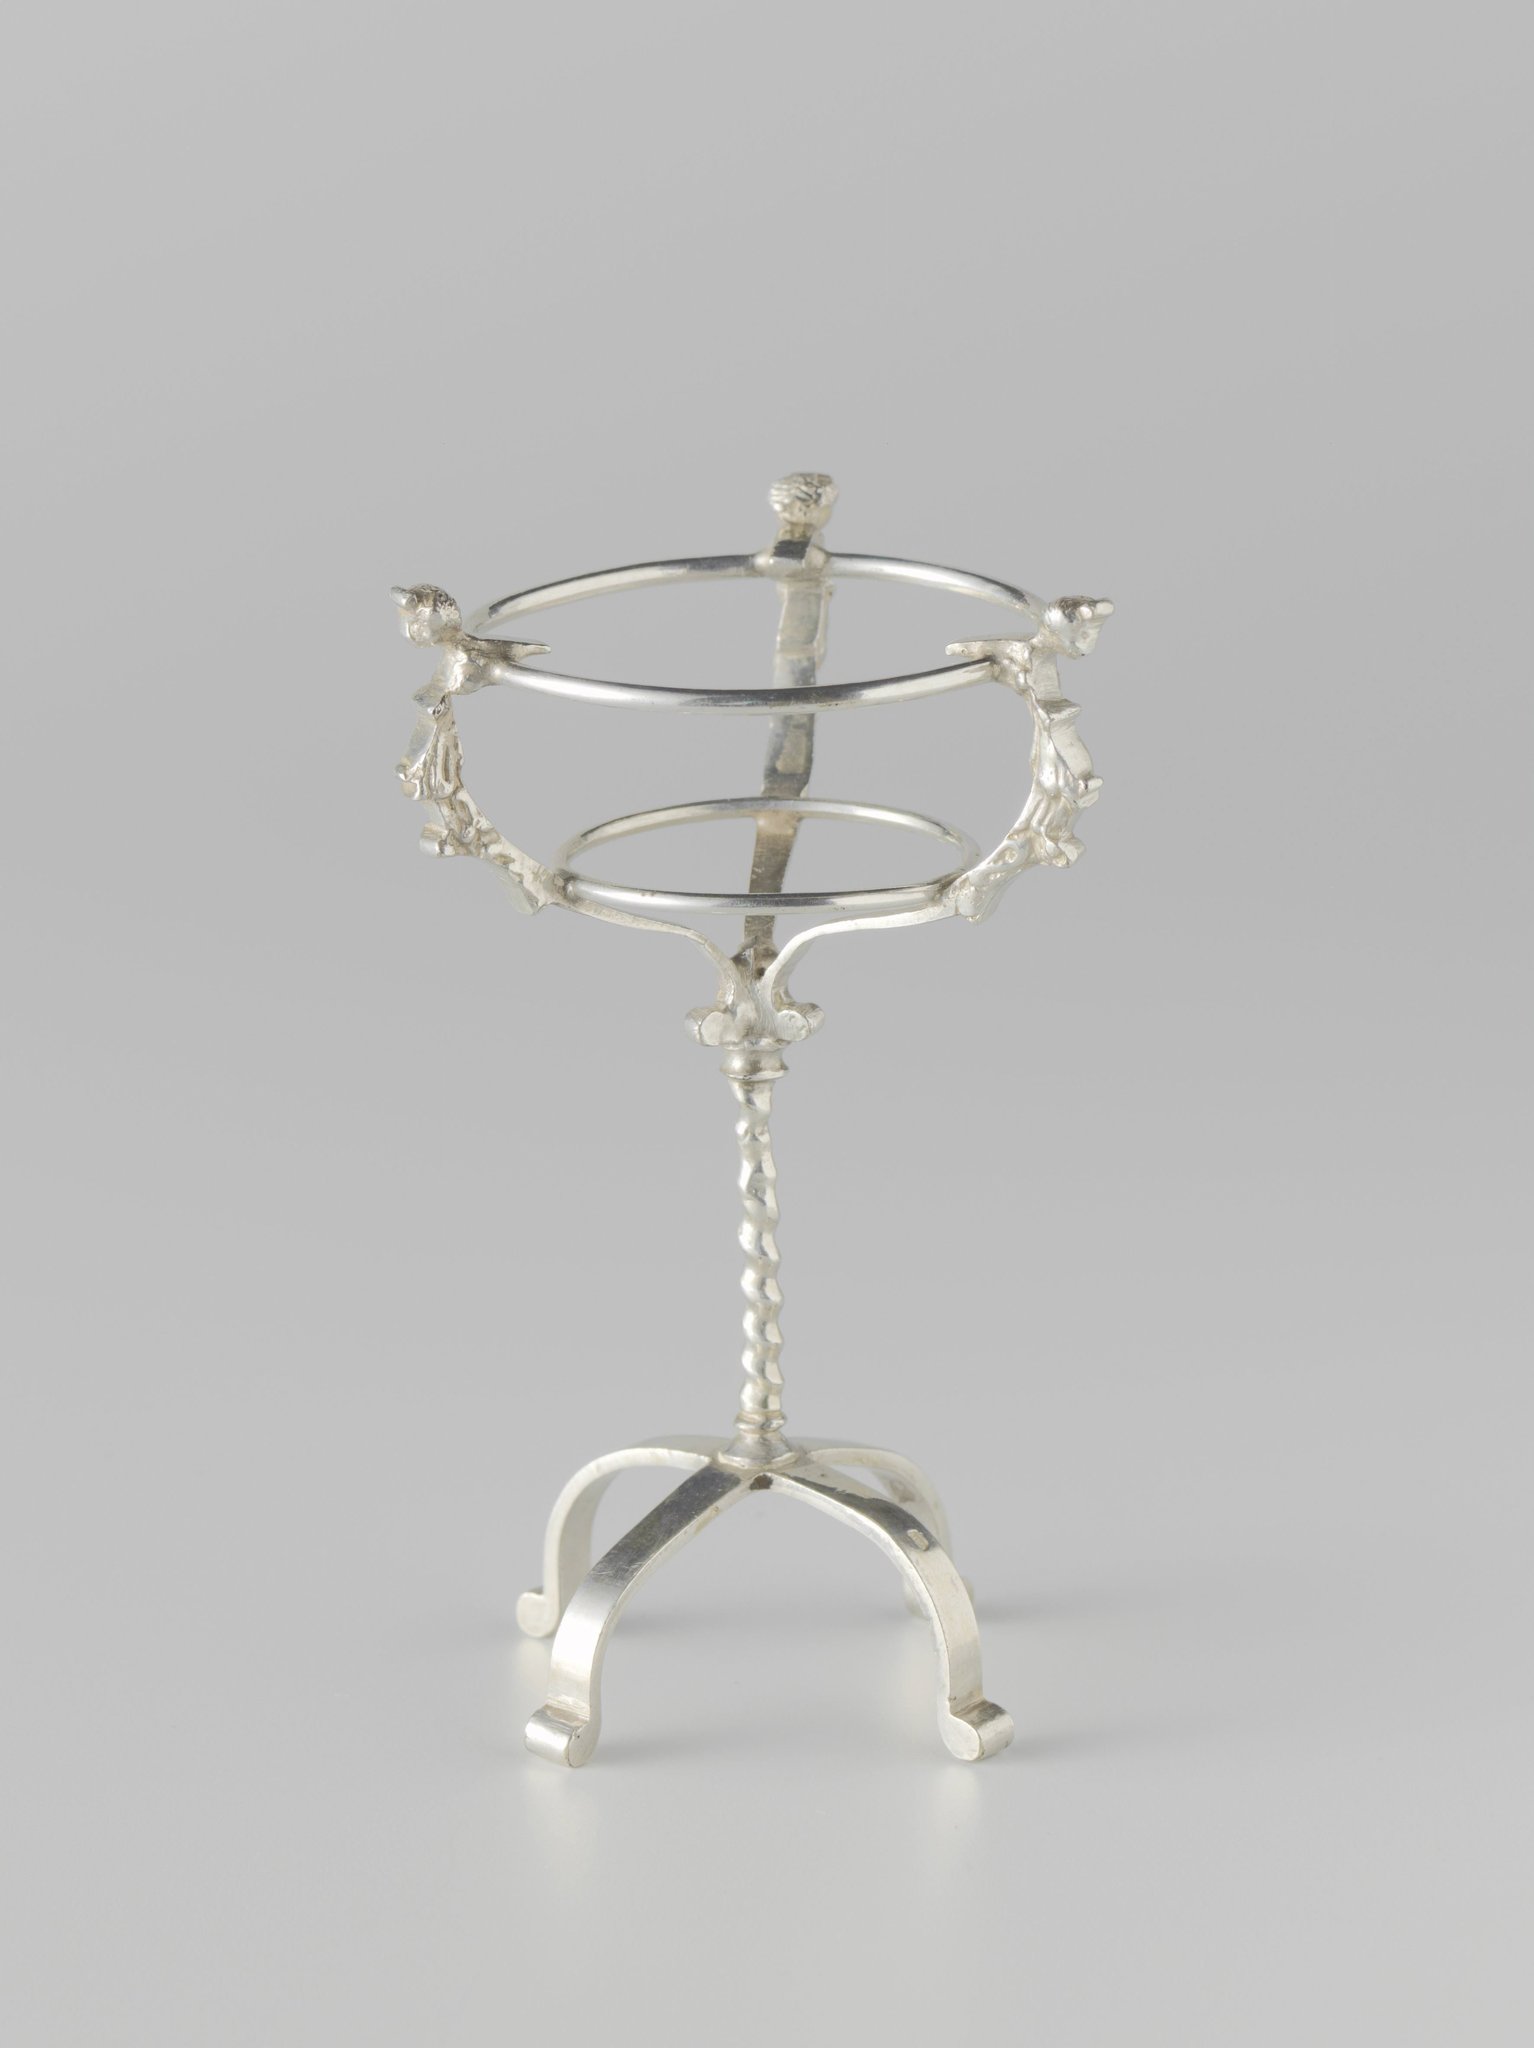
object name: miniature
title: Komfoor op driepoot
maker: Anonymous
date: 1700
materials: silver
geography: netherlands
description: Standaard op een gedraaide stam, die uitloopt in een vierpoot. Op de stam komen vier geprofileerde armen samen die twee draagringen steunen. De standaard is gemerkt: zwijnskop.